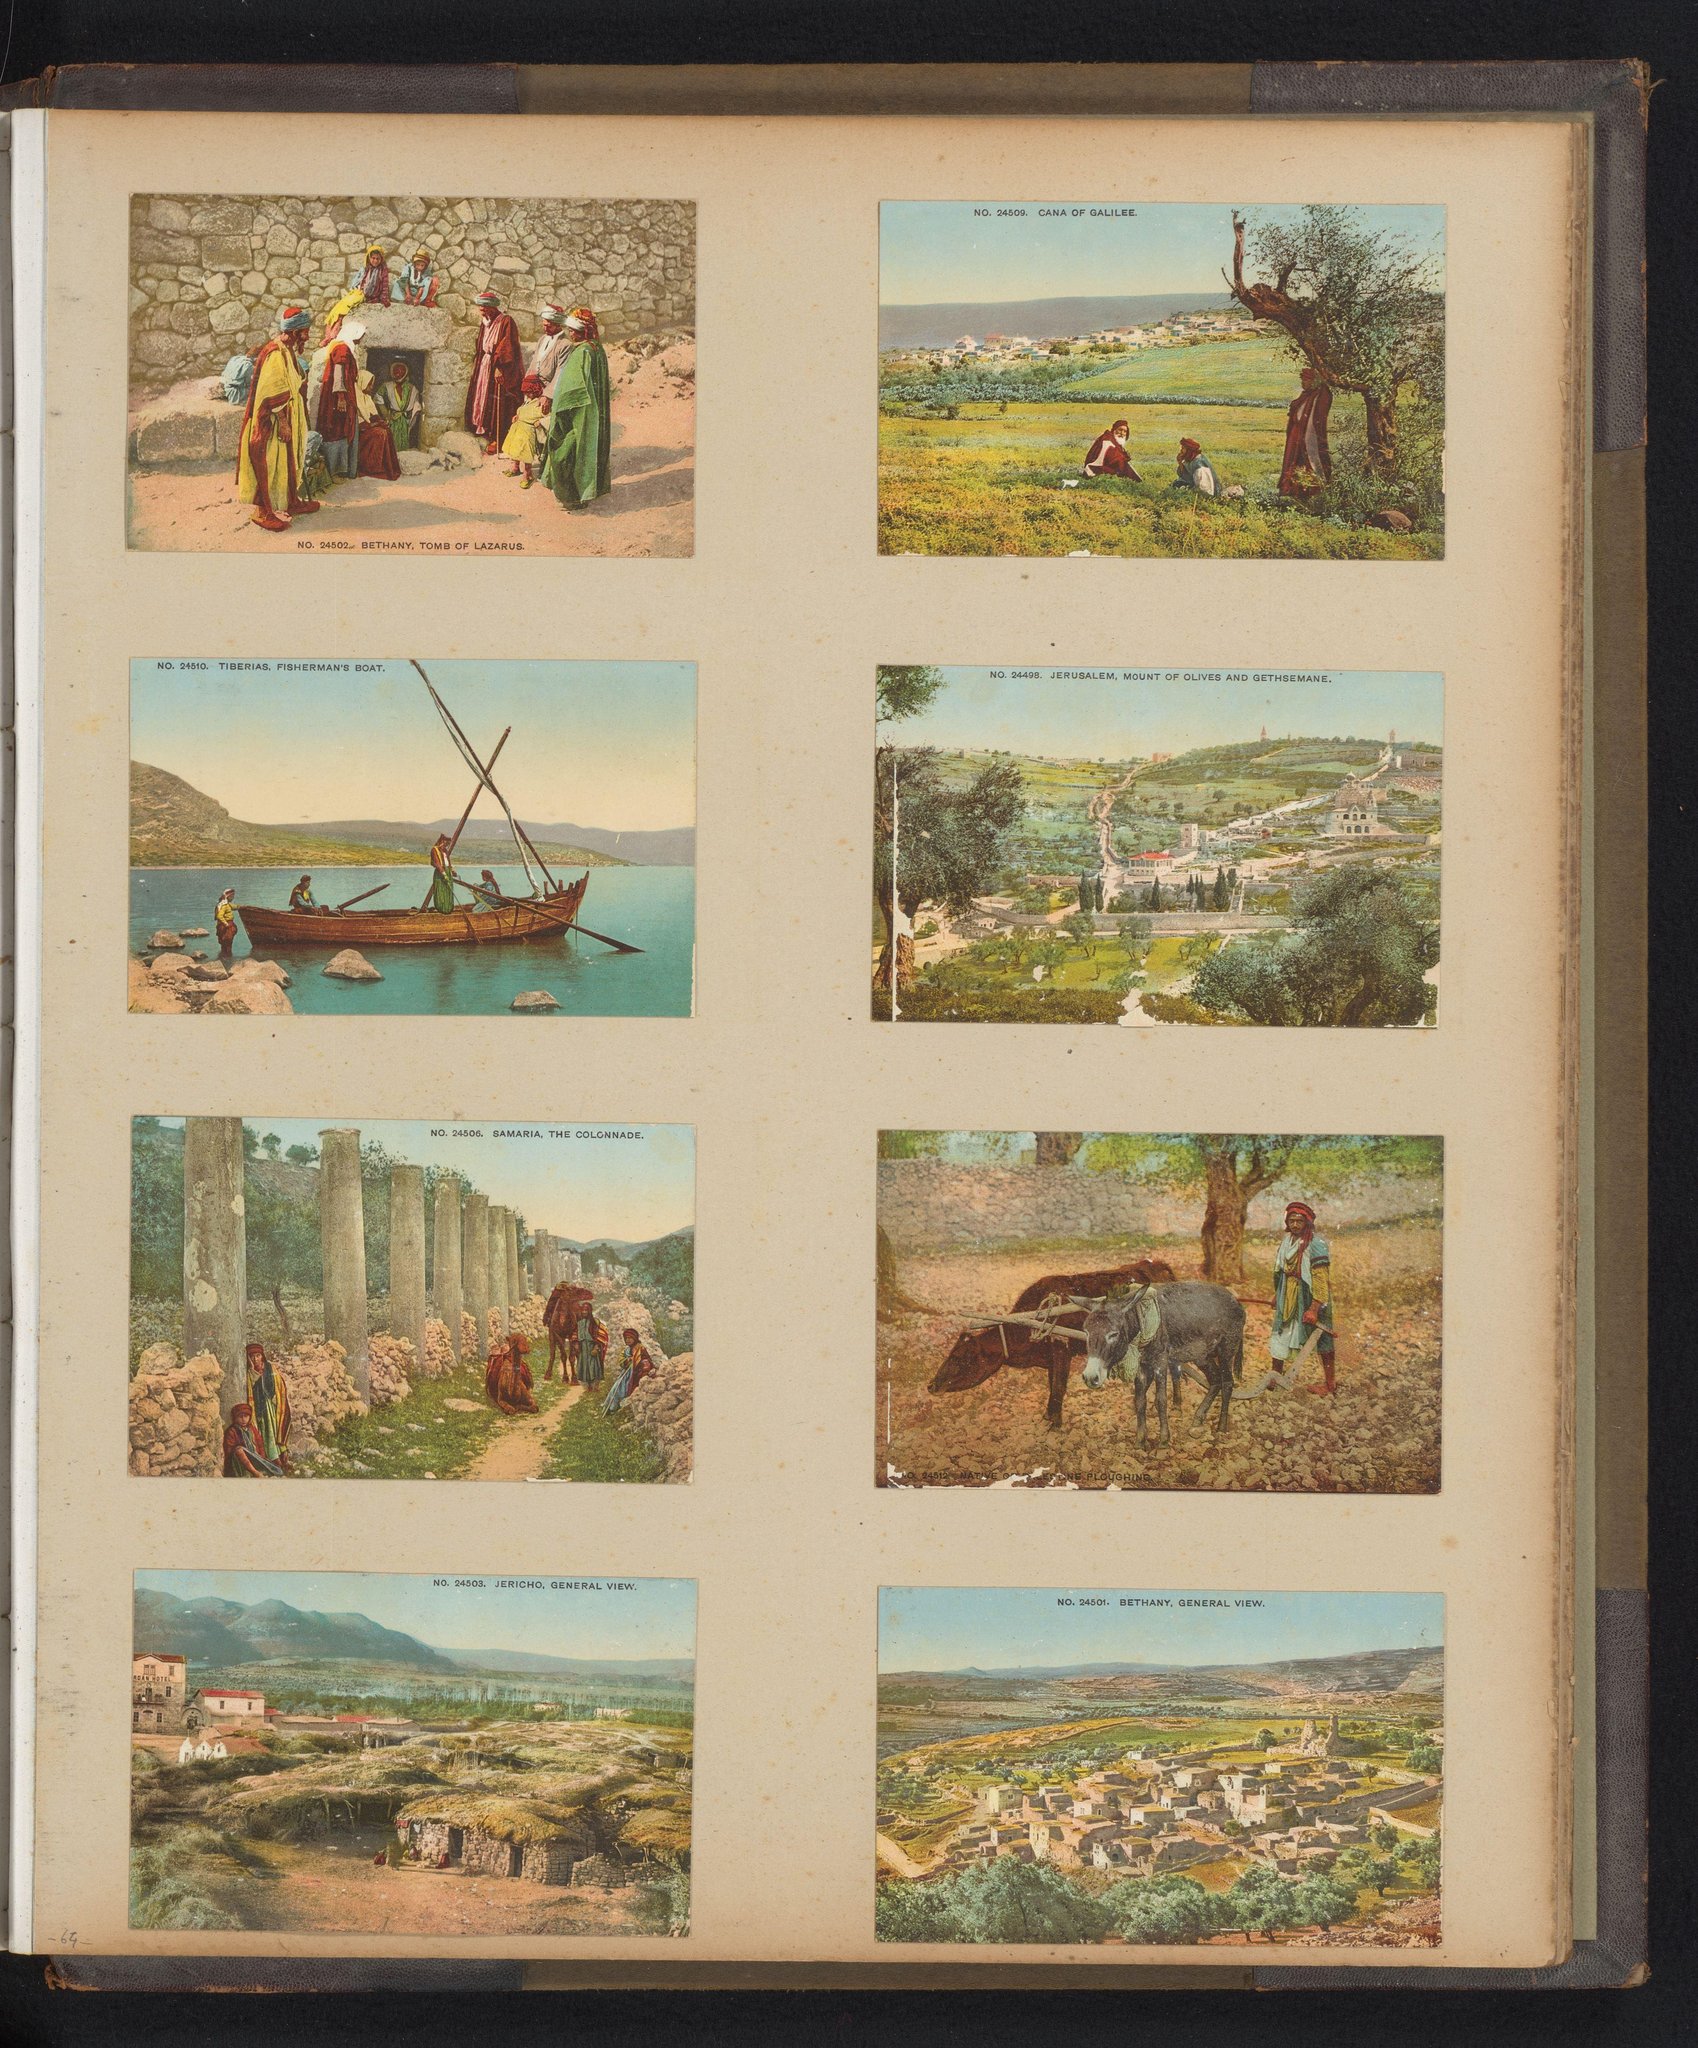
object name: album leaf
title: Acht prentbriefkaarten met gezichten op Jeruzalem, Bethanië, Samaria, Tiberias en Jericho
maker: Anonymous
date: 1871-1910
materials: paper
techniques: photolithography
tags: city-view in general; 'veduta'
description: Deze prent maakt deel uit van een album.